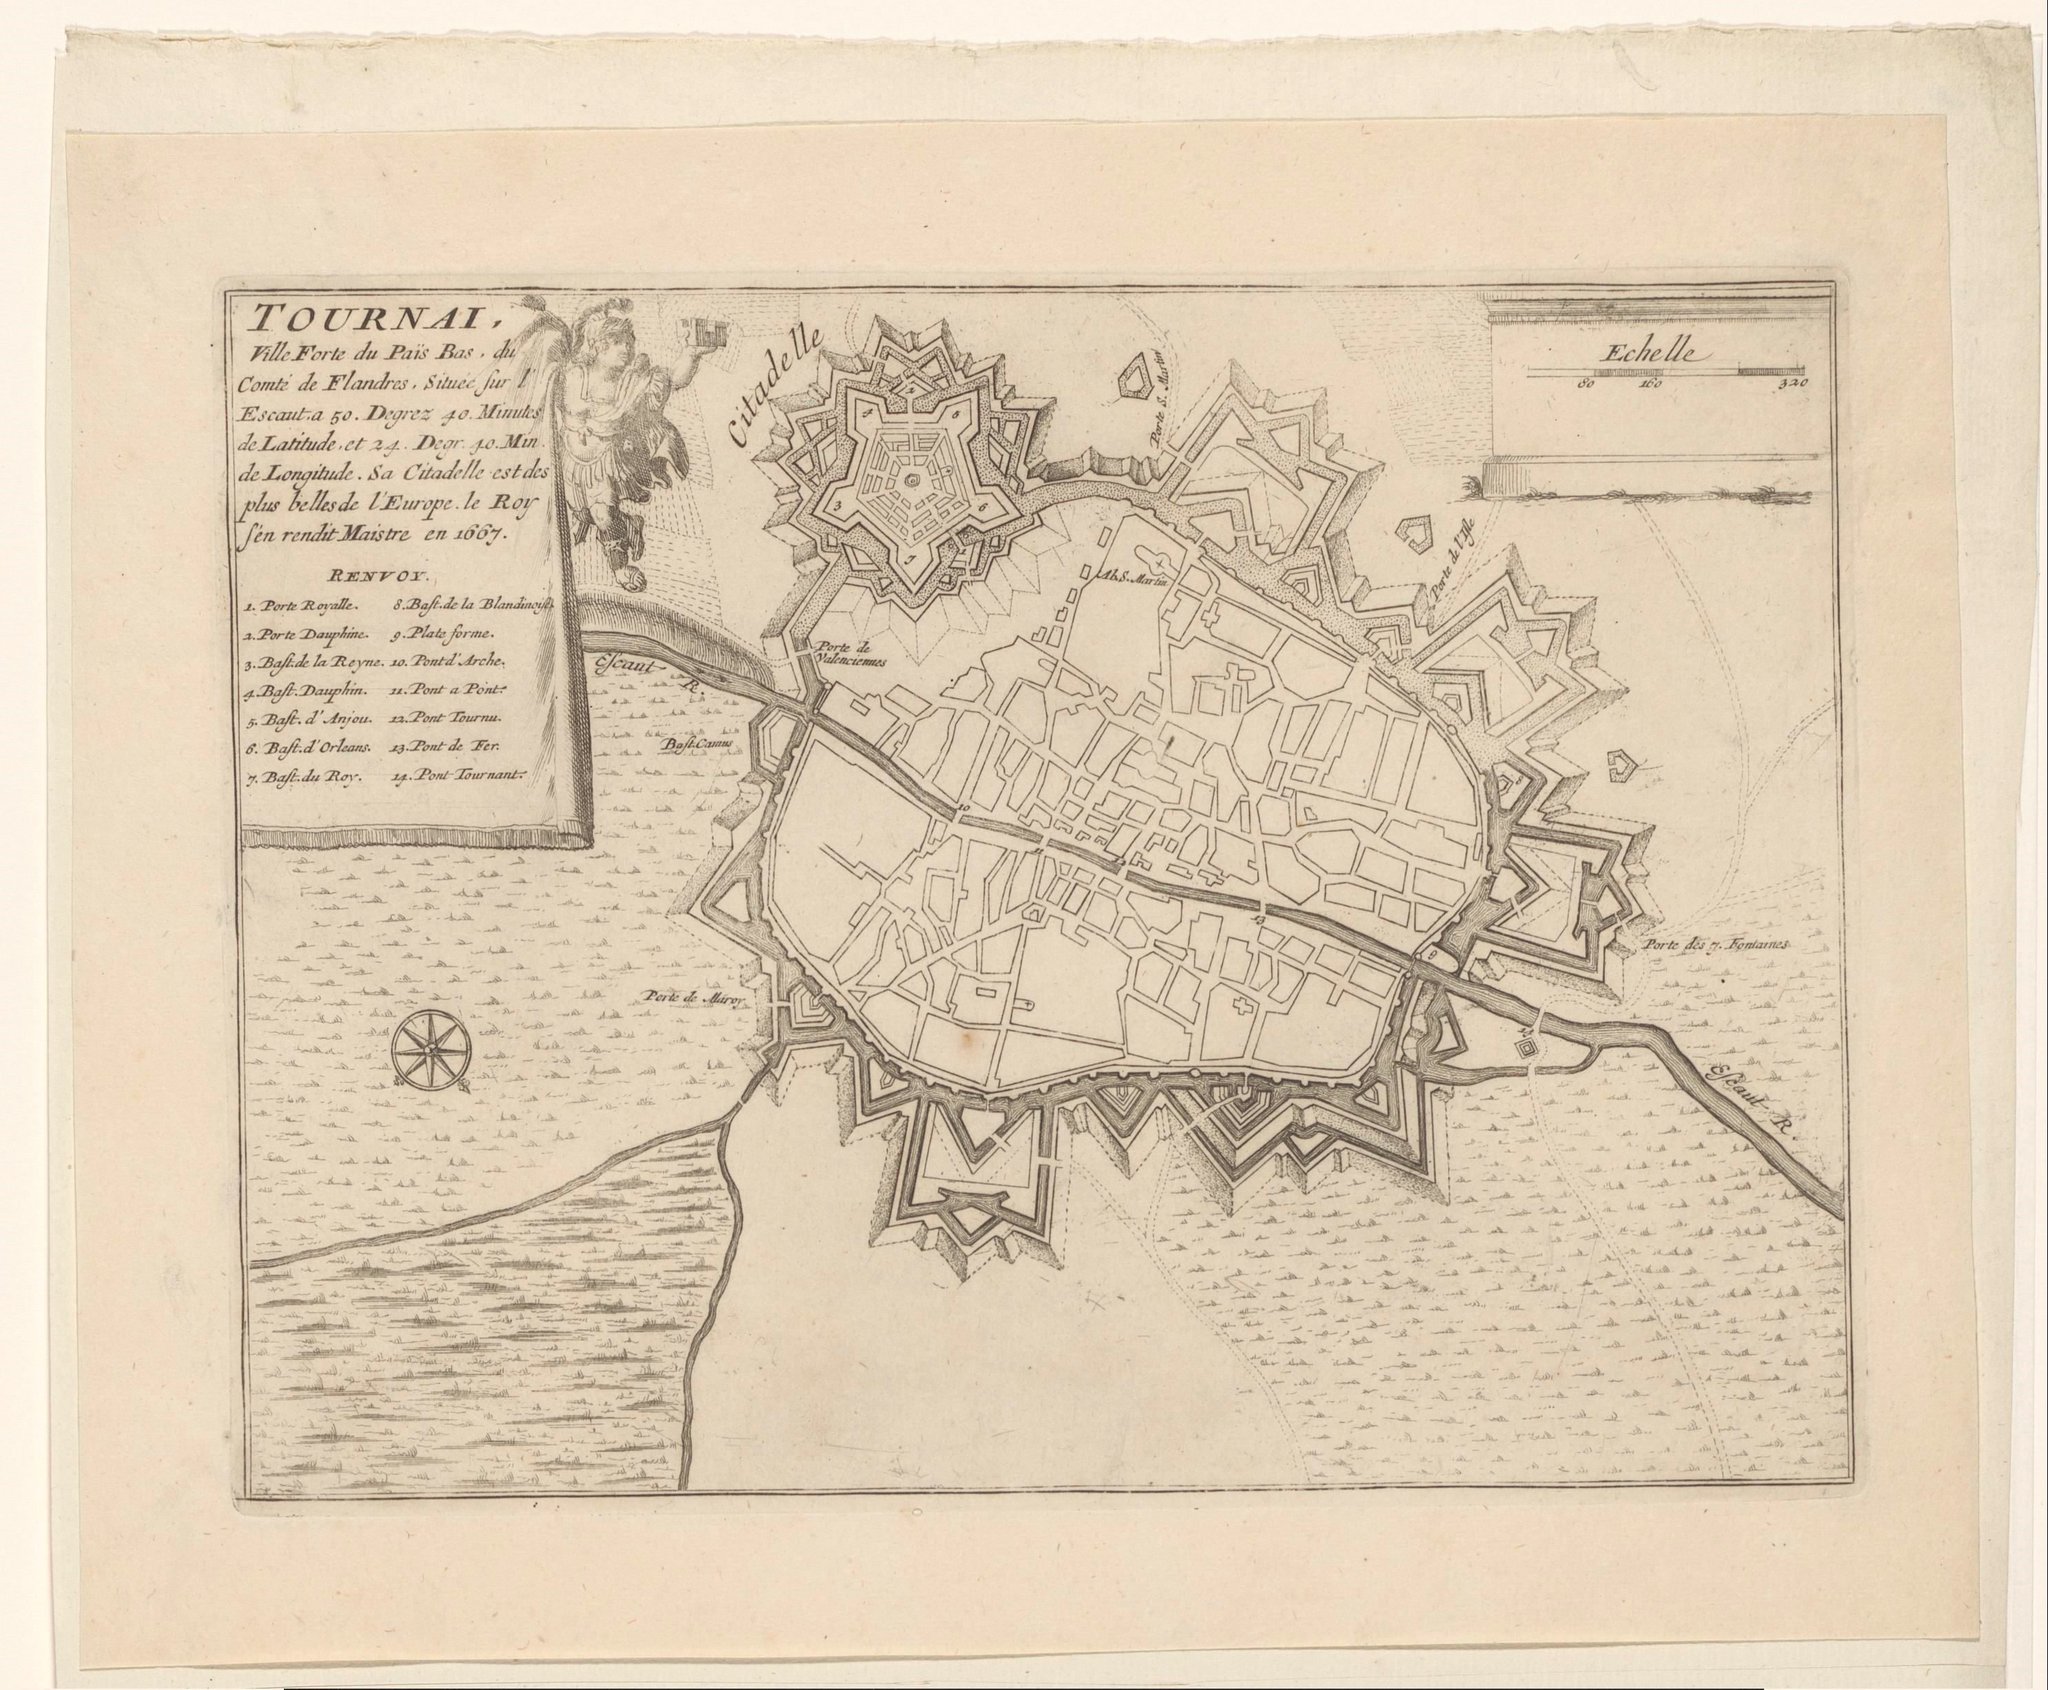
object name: area plan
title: Vestingplattegrond van Doornik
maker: Anonymous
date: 1690-1700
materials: paper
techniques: engraving, etching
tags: fortified city, maps of cities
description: Prent ook gebruikt in: Fer, Nicolas de. Les forces de l'Europe, ou description des principales villes, avec leurs fortifications : dessignées par les meilleurs ingenieurs, particulierement celles (…). Parijs: Nicolas de Fer, 1690-1695. En in: Las Fuerzas de la Europa, o la descripcion de las principales ciudades (…). Amsterdam: George Gallet, 1700.